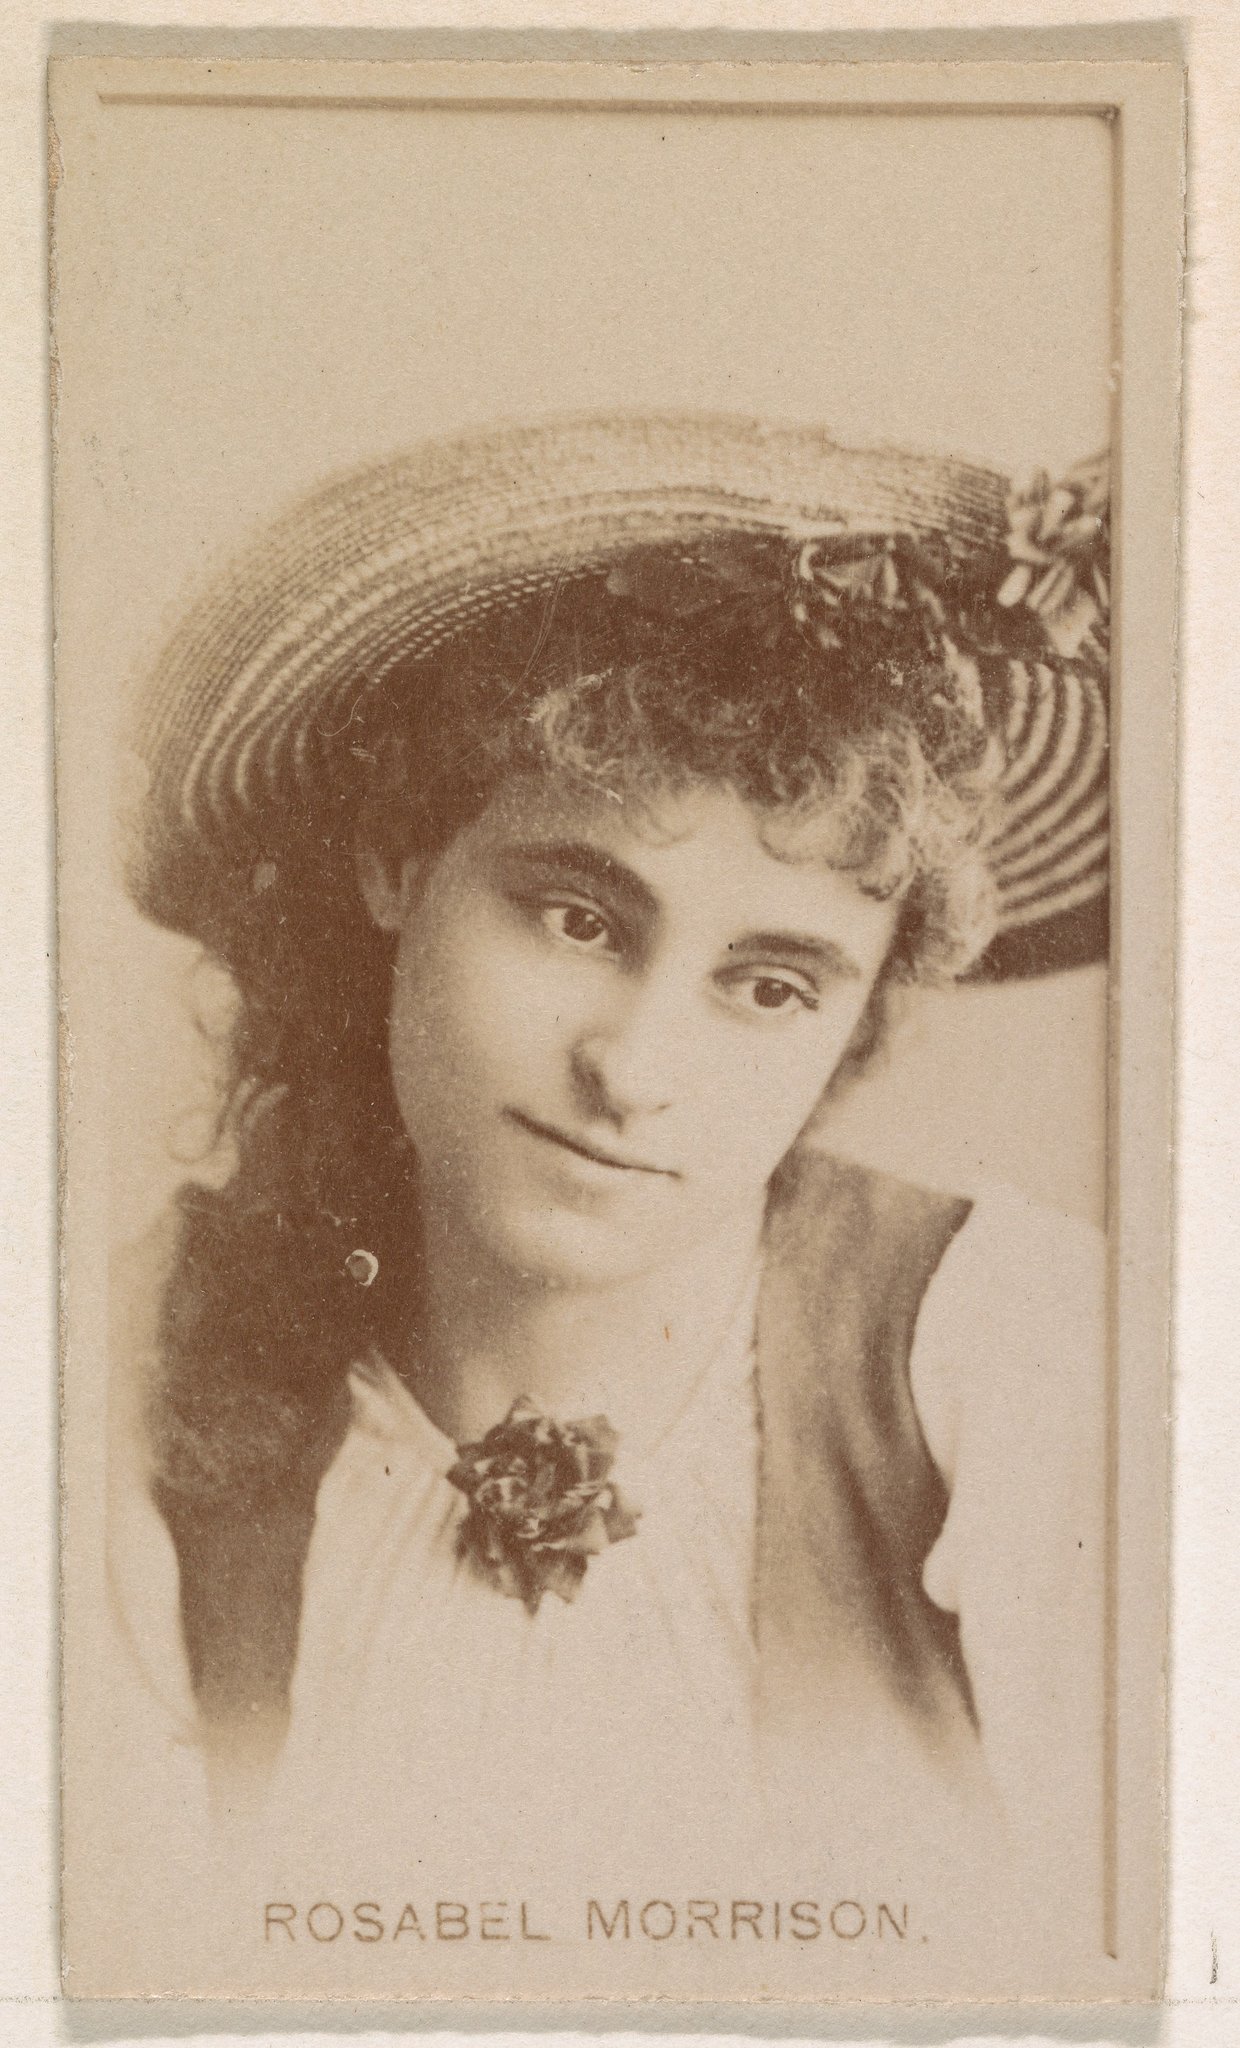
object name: photograph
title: Rosabel Morrison, from the Actresses series (N245) issued by Kinney Brothers to promote Sweet Caporal Cigarettes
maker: kinney brothers tobacco company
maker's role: publisher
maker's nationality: american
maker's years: 1869-2011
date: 1890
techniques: albumen silver print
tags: portraits,women,actresses